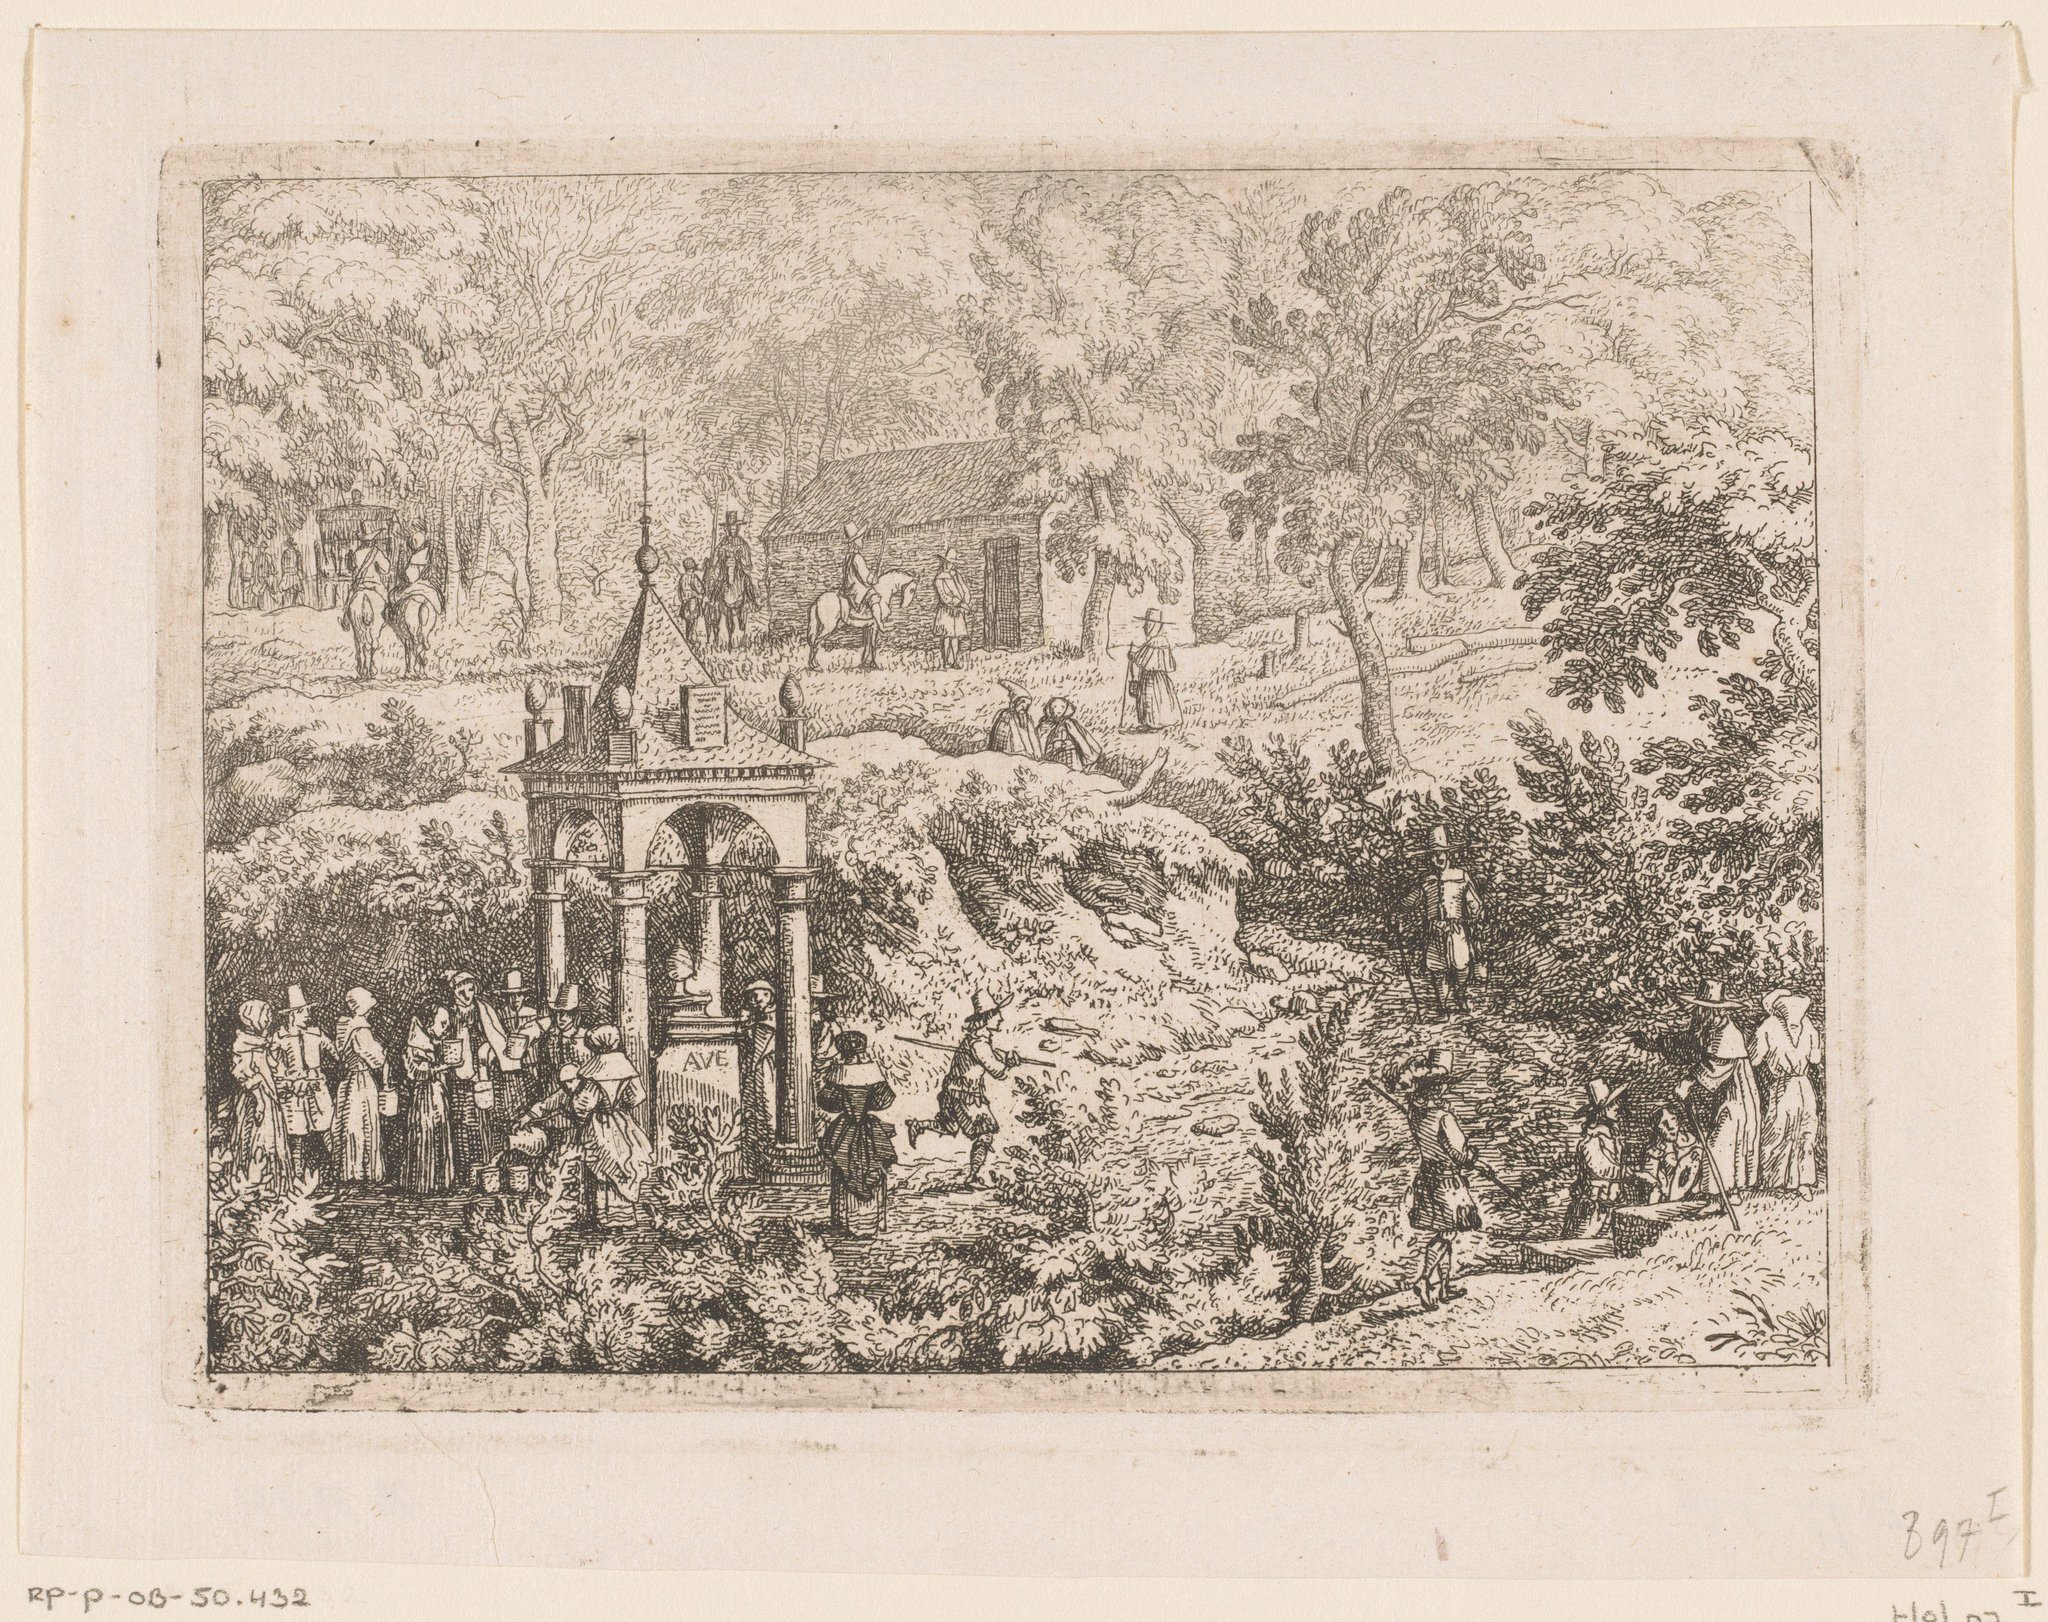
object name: print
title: Vier waterbronnen in en rond Spa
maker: allaert van everdingen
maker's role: draughtsman, painter, print maker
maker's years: 1621-1675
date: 1655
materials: paper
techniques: etching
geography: netherlands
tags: spring (fluids extracted from the earth)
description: Landschap met op de achtergrond bomen en een stenen gebouw. Bij een torenachtig gebouw op de voorgrond wachten mensen op hun beurt om water te halen.